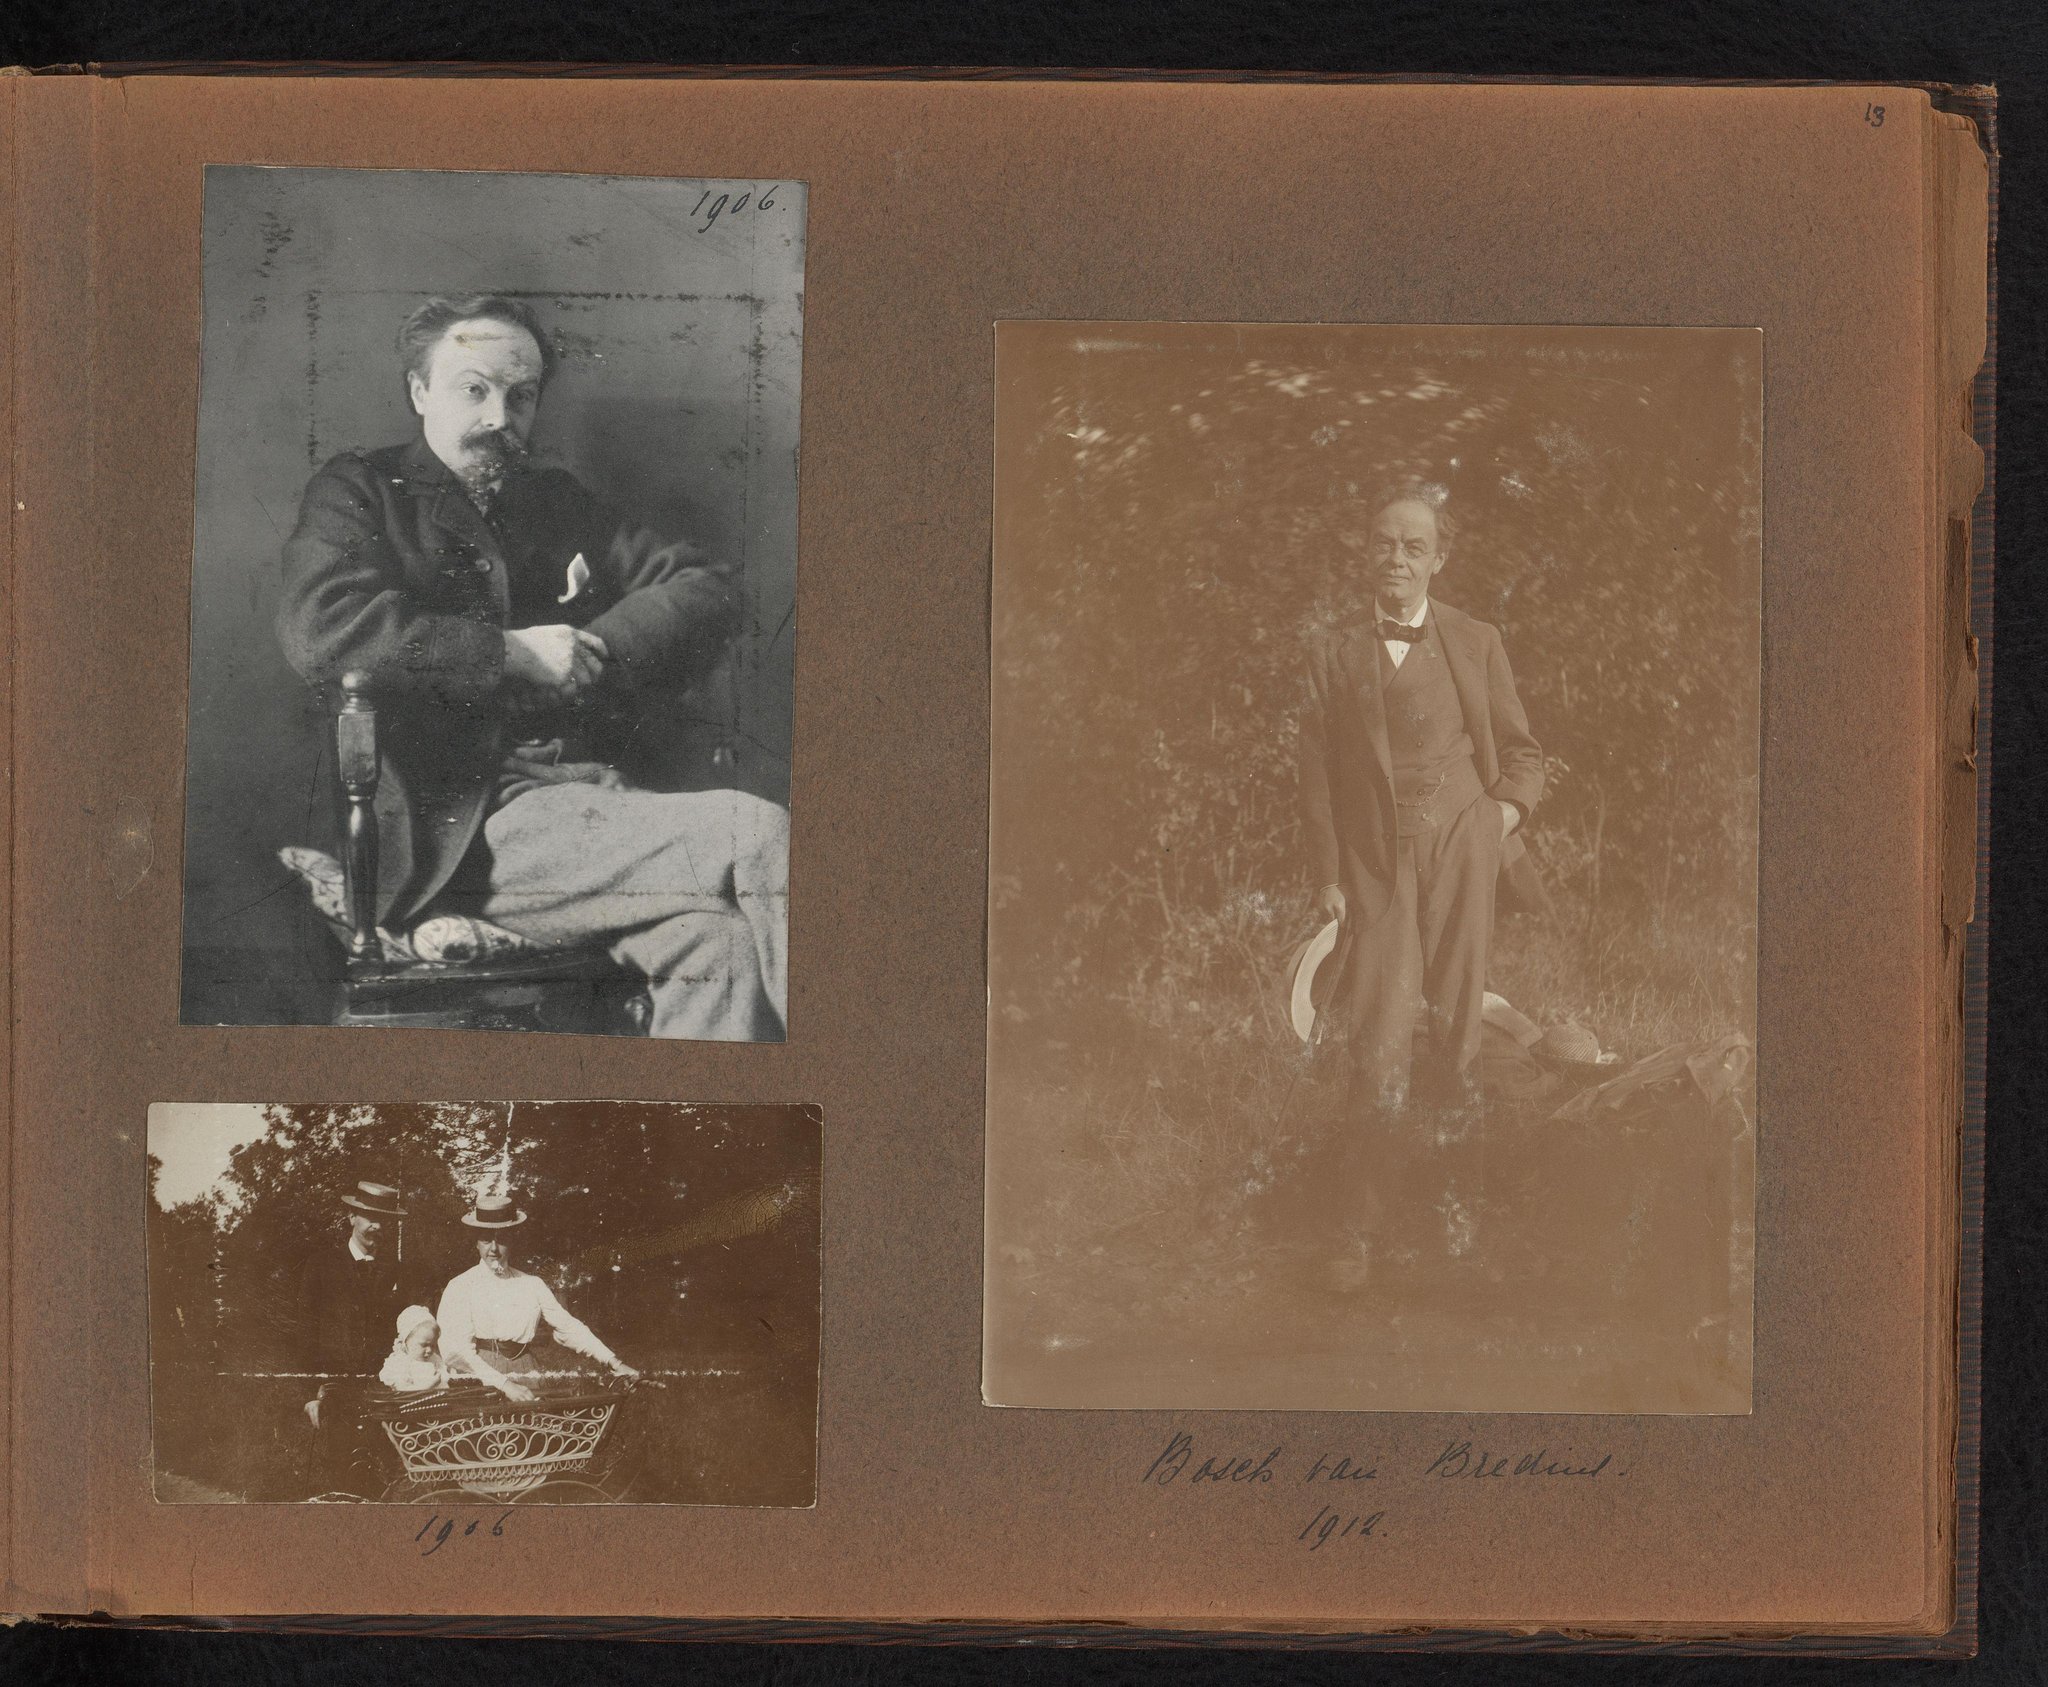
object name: photograph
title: Bladzijde uit het fotoalbum van de familie Diepenbrock met 3 foto's van Alphons Diepenbrock en zijn omgeving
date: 1899-1912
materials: cardboard, photographic support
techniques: photography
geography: amsterdam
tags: amsterdam, alphons diepenbrock, jonkvrouw wilhelmina elisabeth petronella cornelia de jong van beek en donk, dordrecht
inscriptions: inscription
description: Bruin albumblad 13 van familiealbum van Alphons Diepenbrock.